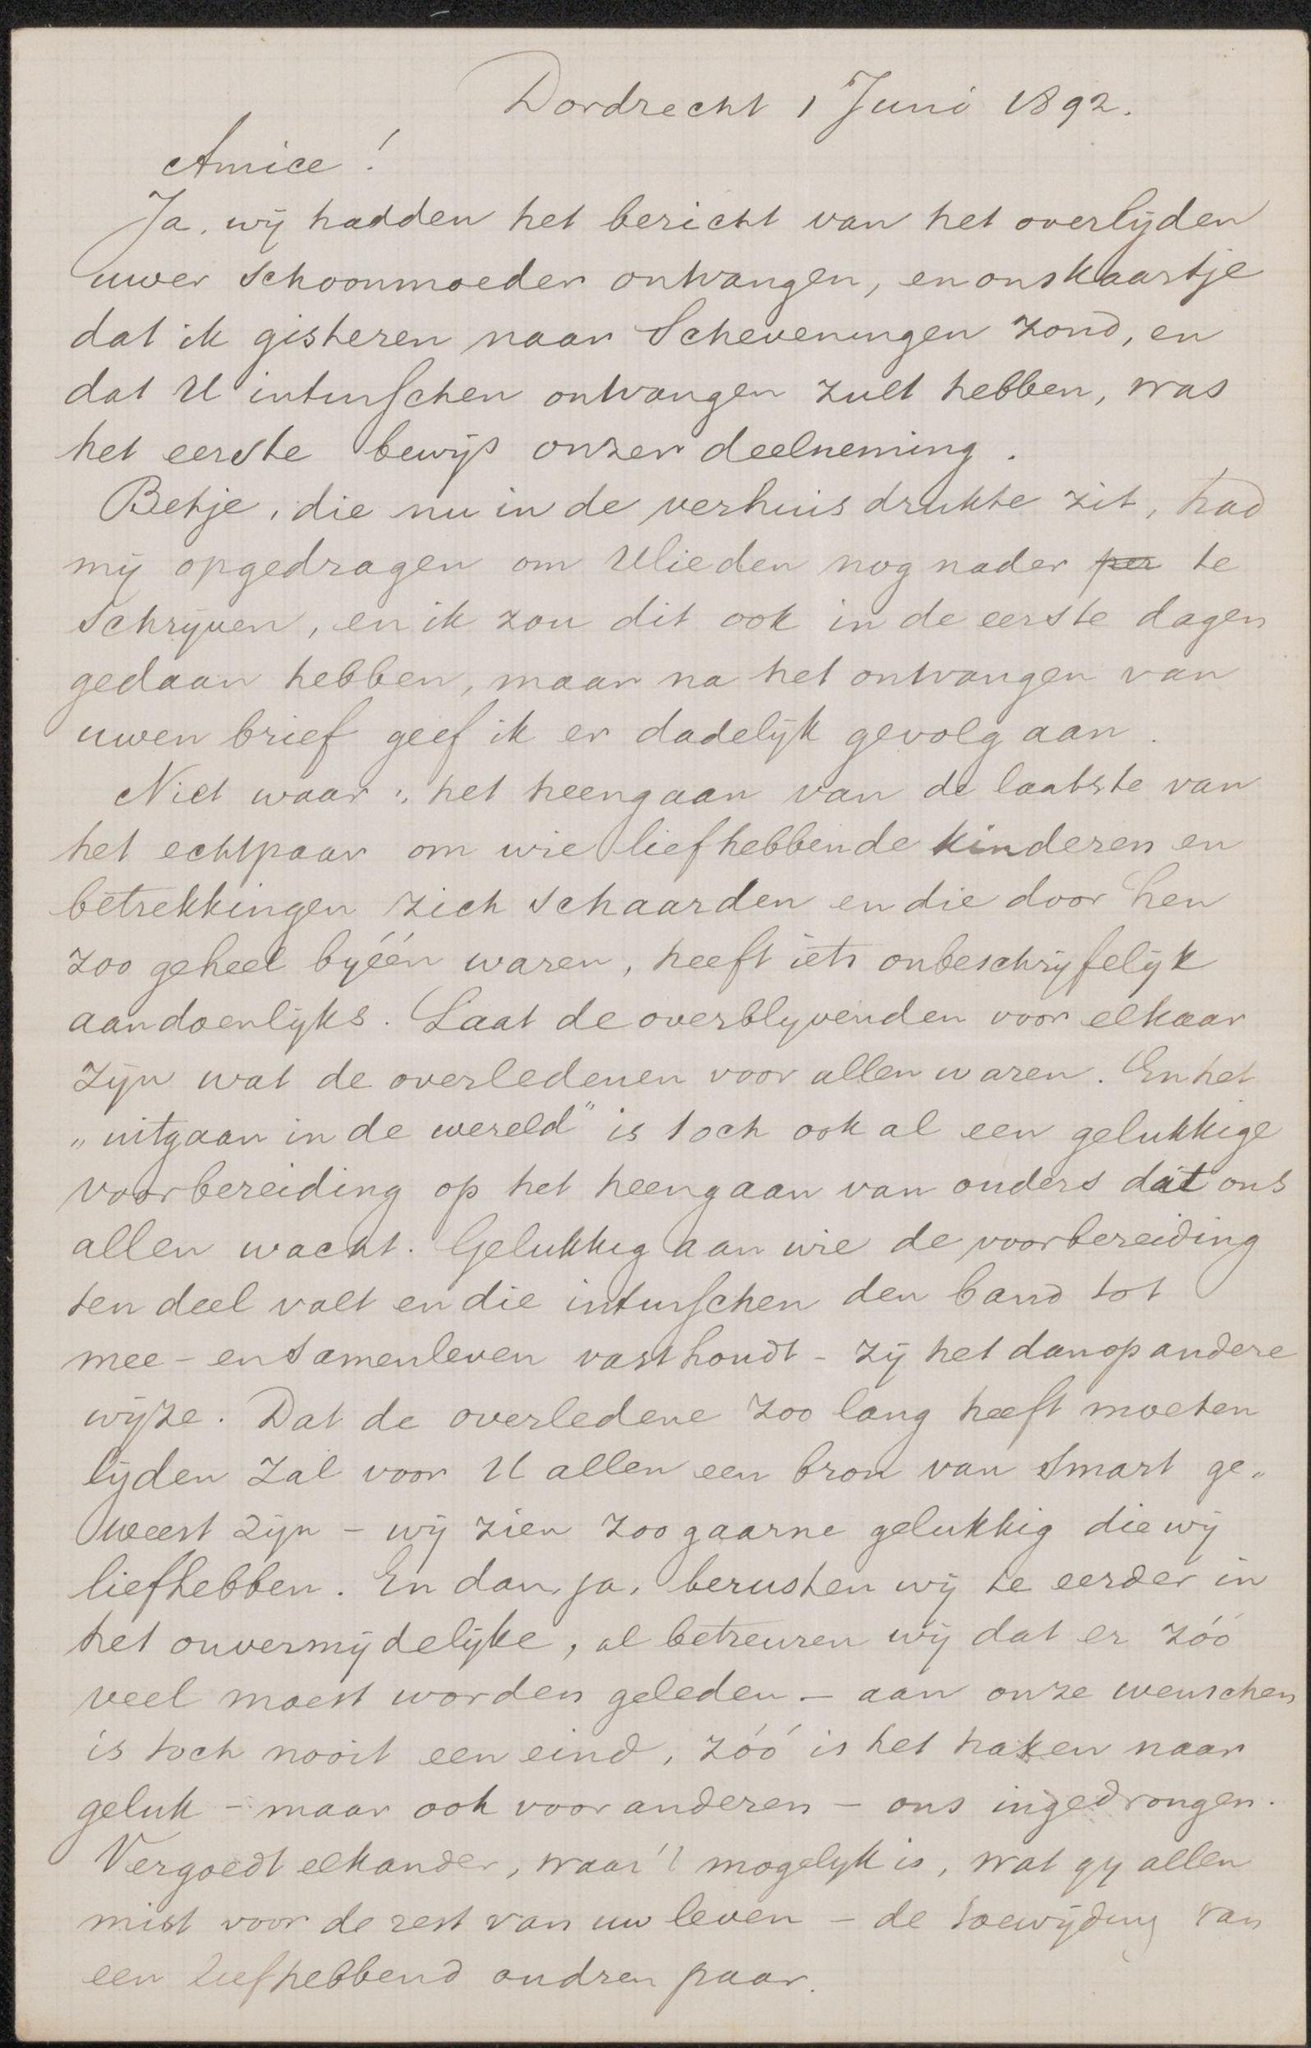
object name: letter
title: Brief aan Jan Veth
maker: martinus cornelis lebret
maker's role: verzamelaar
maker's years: 1833-1894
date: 1892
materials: ink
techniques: pen, writing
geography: dordrecht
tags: dordrecht, print maker, designer, jan veth, the hague, london, matthijs maris, eduard karsen, amsterdam, physicist, haarlem, painter, draughtsman, family life, exhibition ~ art, diseases, charitable works, money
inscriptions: collector's mark: ‘RPK’